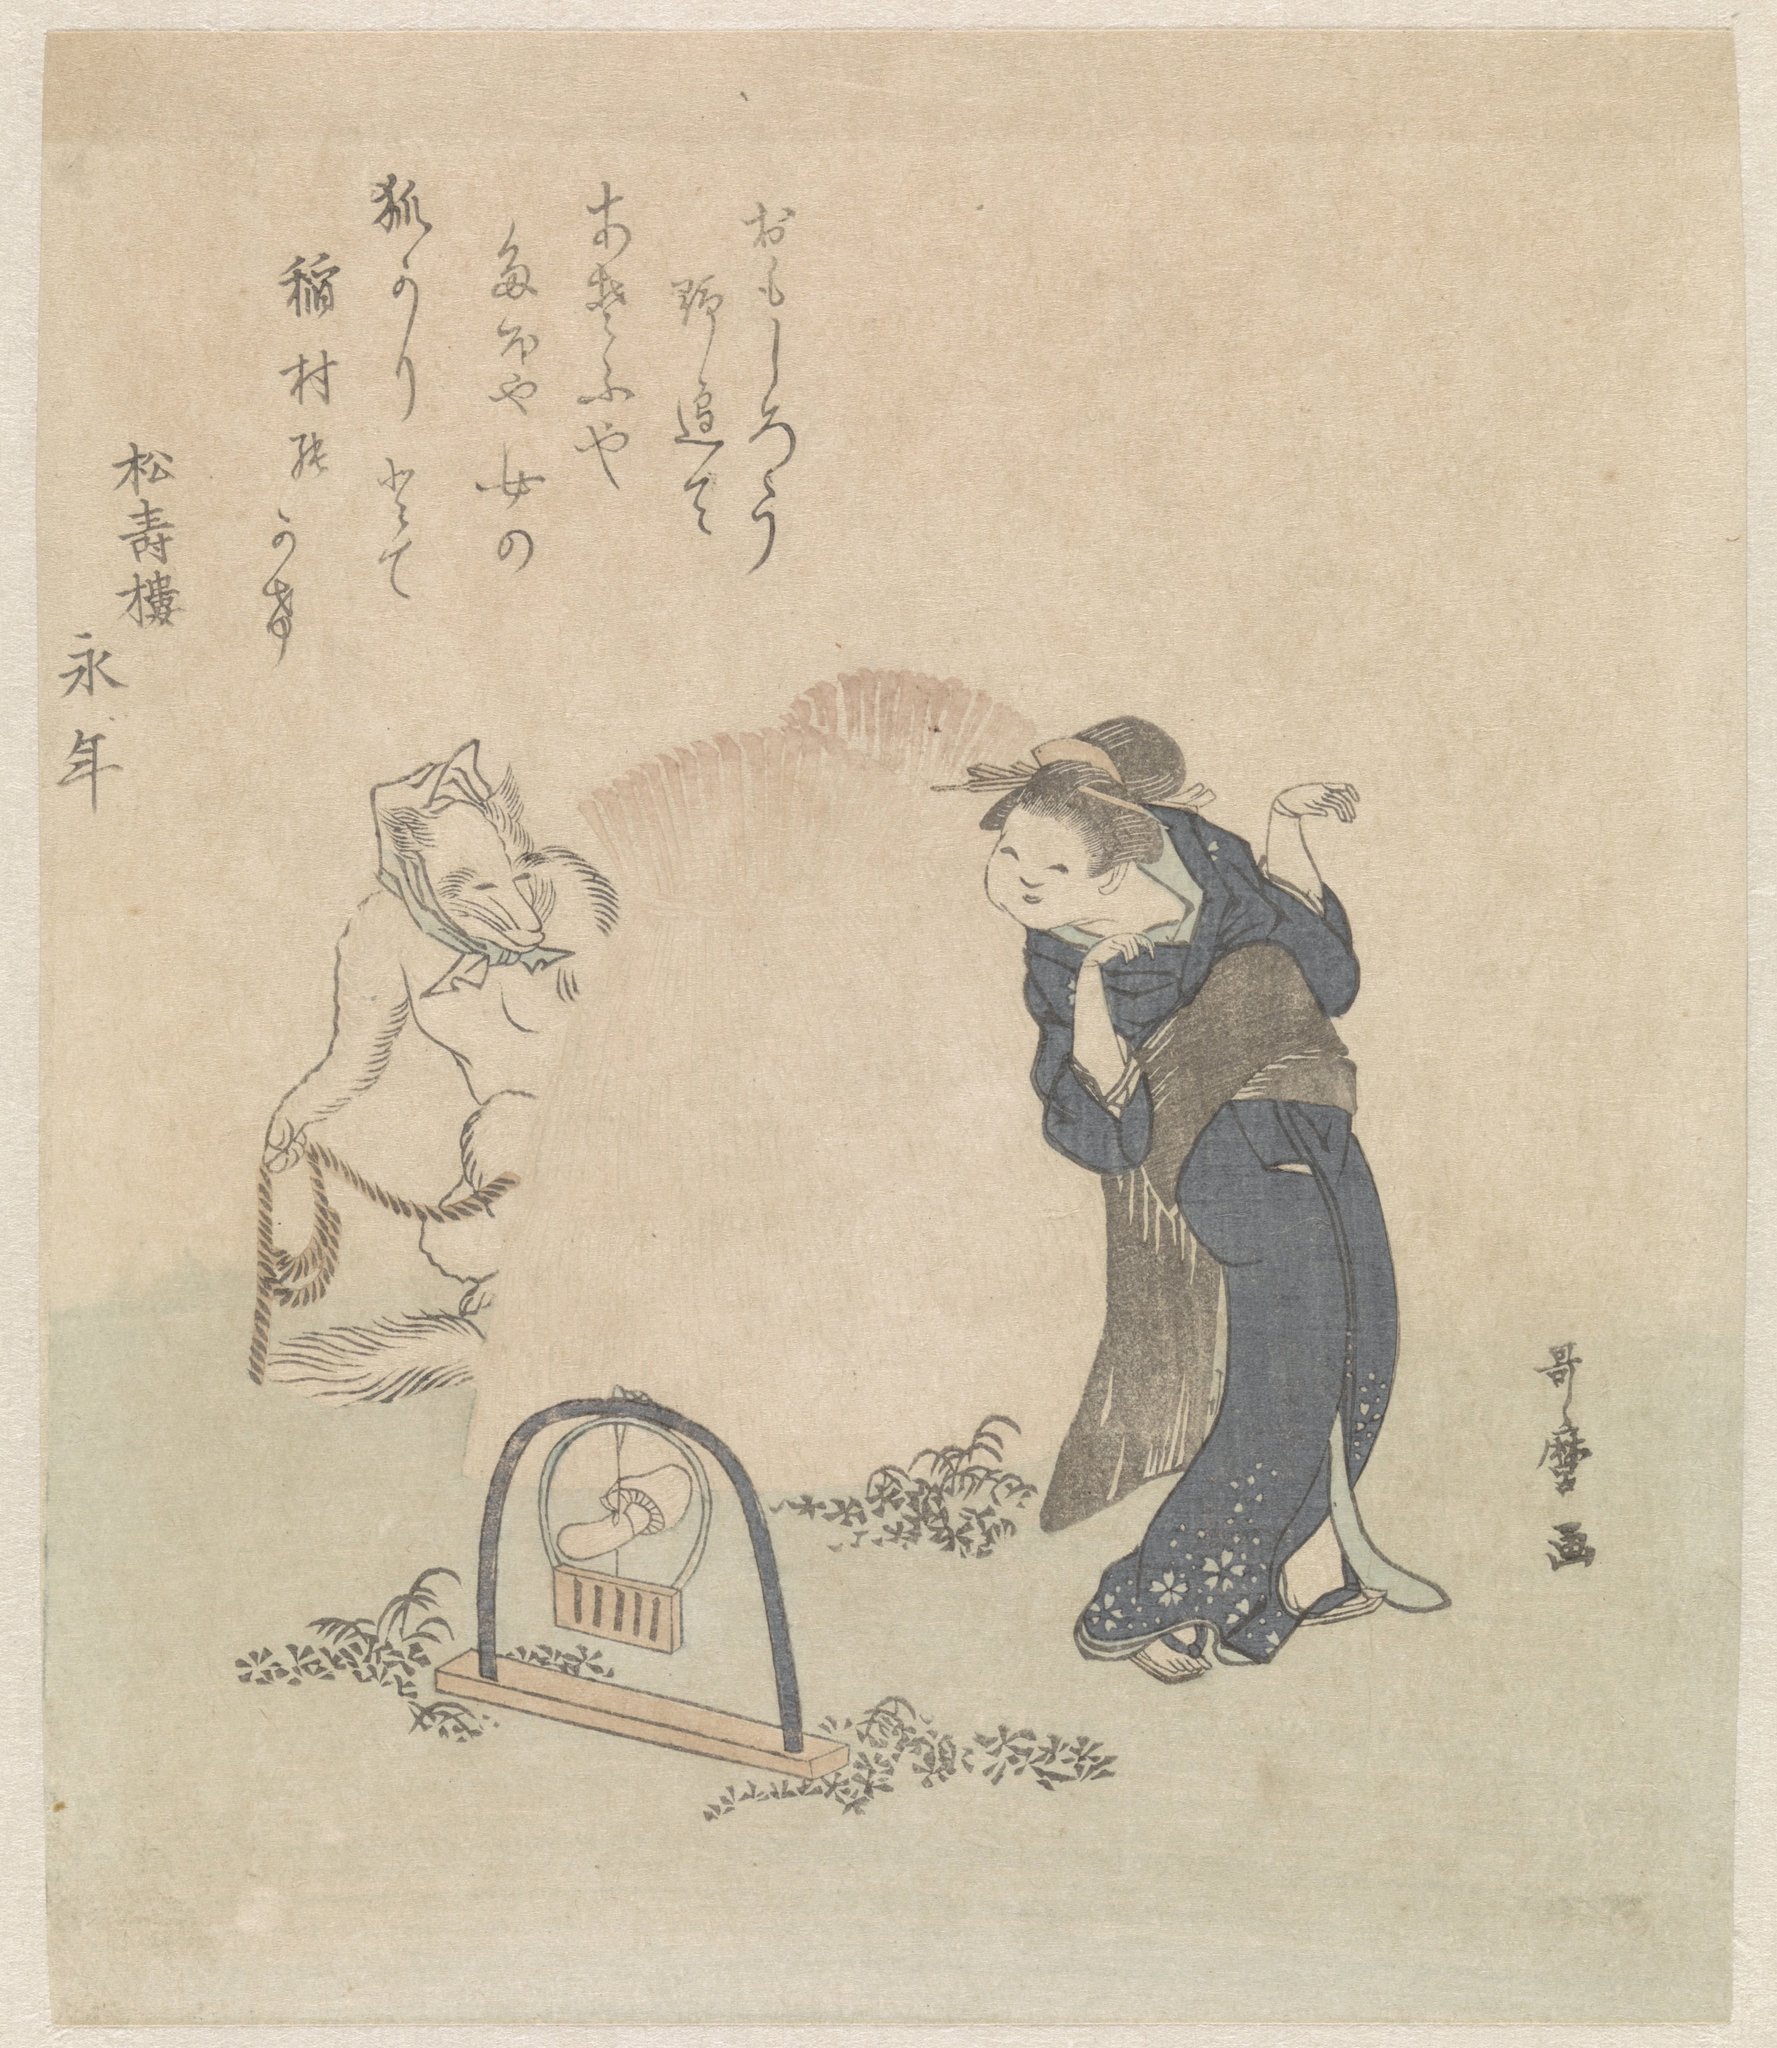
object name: surimono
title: Vrouw bij een vossenklem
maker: kitagawa utamaro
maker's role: print maker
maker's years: 1753-1806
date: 1890-1900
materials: paper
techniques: blind stamped, woodcut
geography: japan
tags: fox hunting, beasts of prey, predatory animals: fox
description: Een surimono is een luxe uitgevoerde prent waarop beeld met één of meerdere gedichten gecombineerd is. Bij het drukken van een surimono werd vaak gebruik gemaakt van dikker papier, blinddruk en metaal pigmenten, zoals koper- en zilverpoeder. De prenten werden vaak in opdracht van dichters gemaakt en als exclusief geschenk aan vrienden en relaties gegeven.